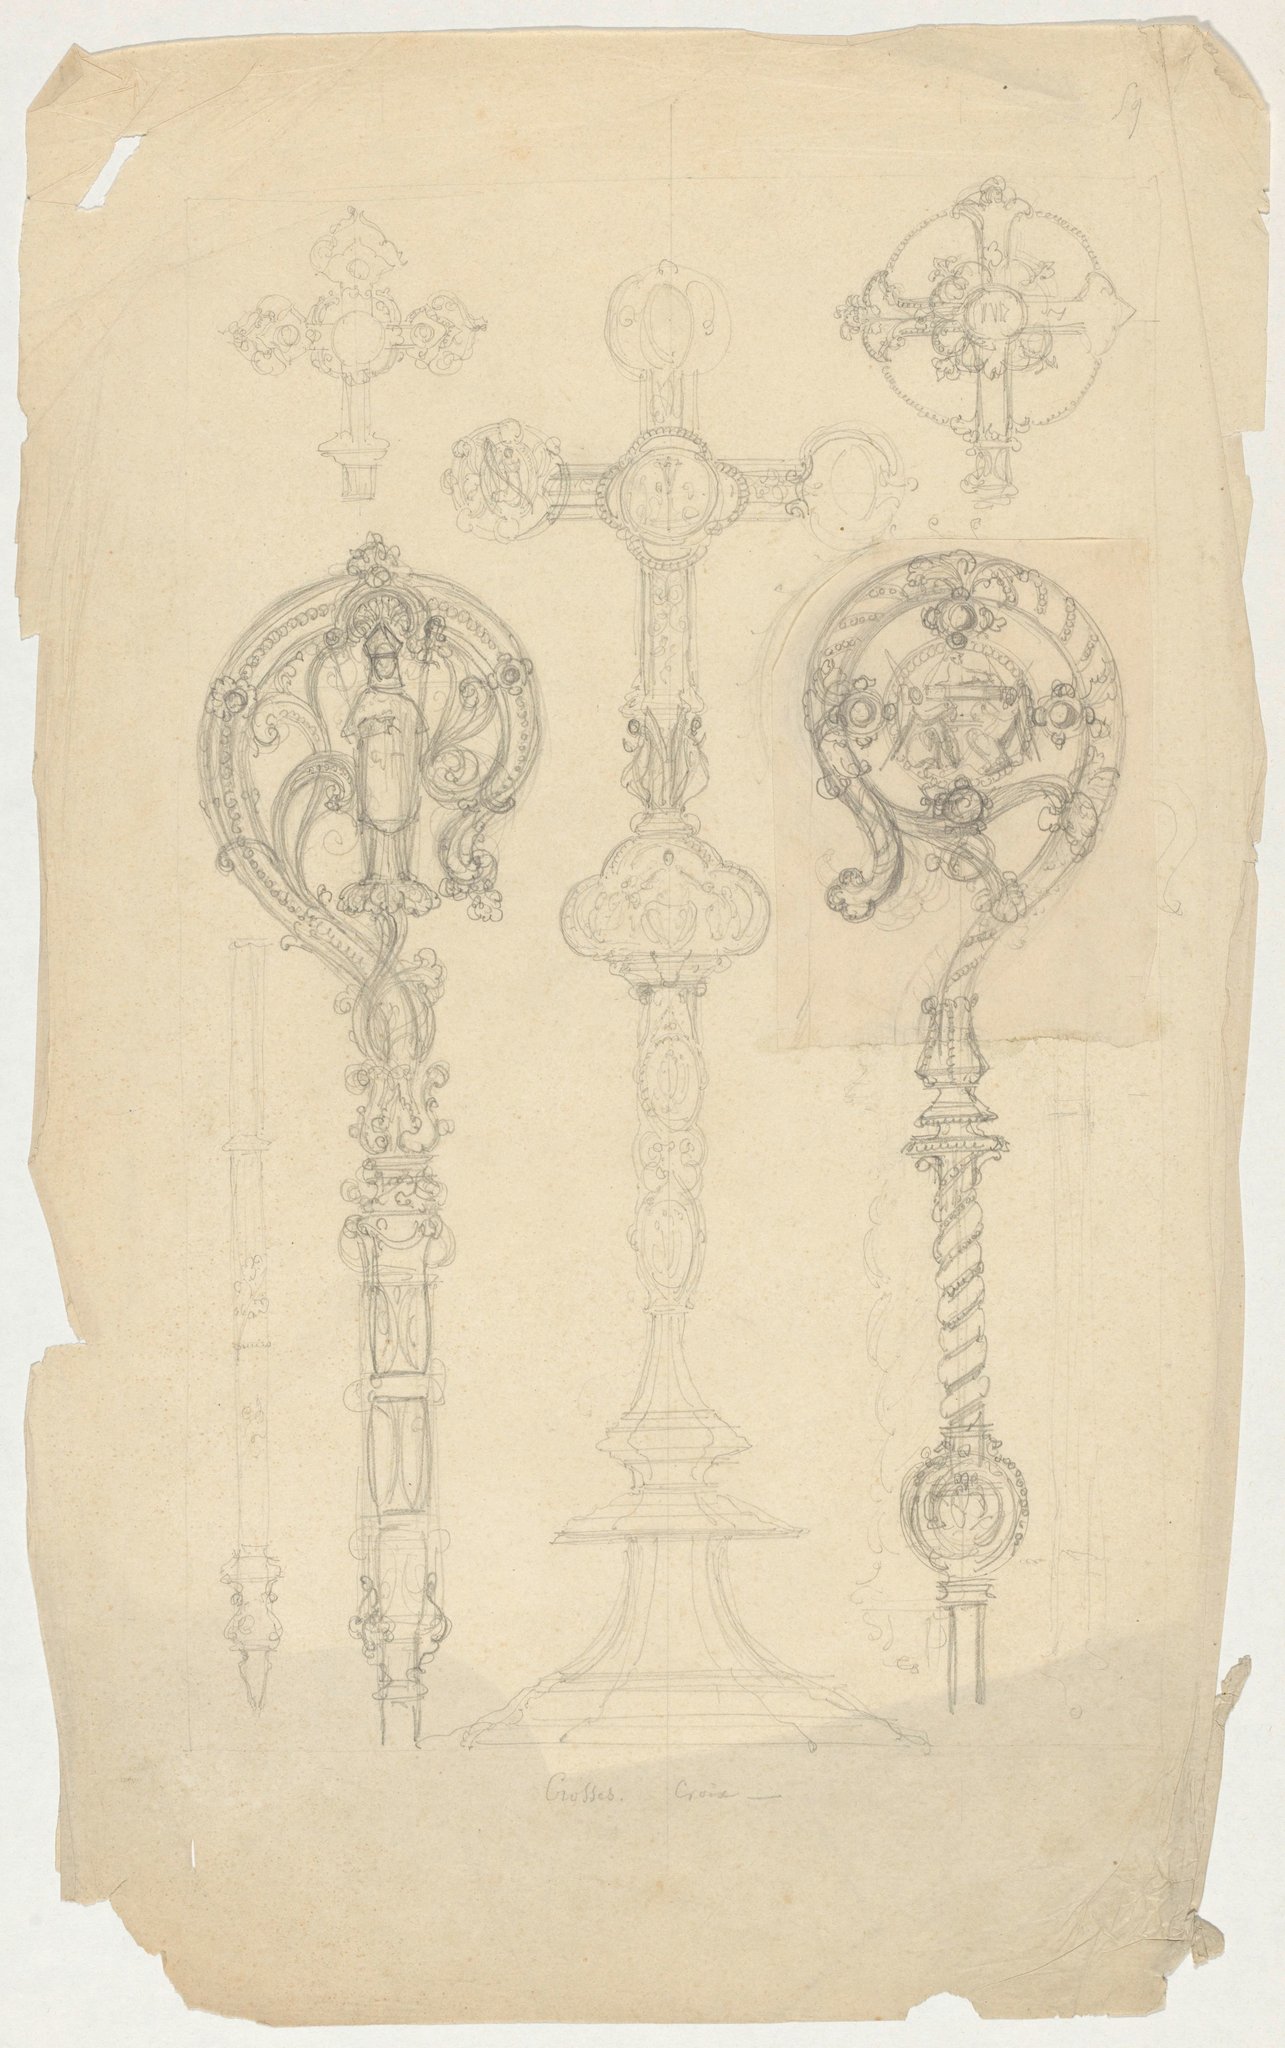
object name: design drawing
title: Crucifix en twee bekroningen voor een staf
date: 1830-1850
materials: graphite, paper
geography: paris